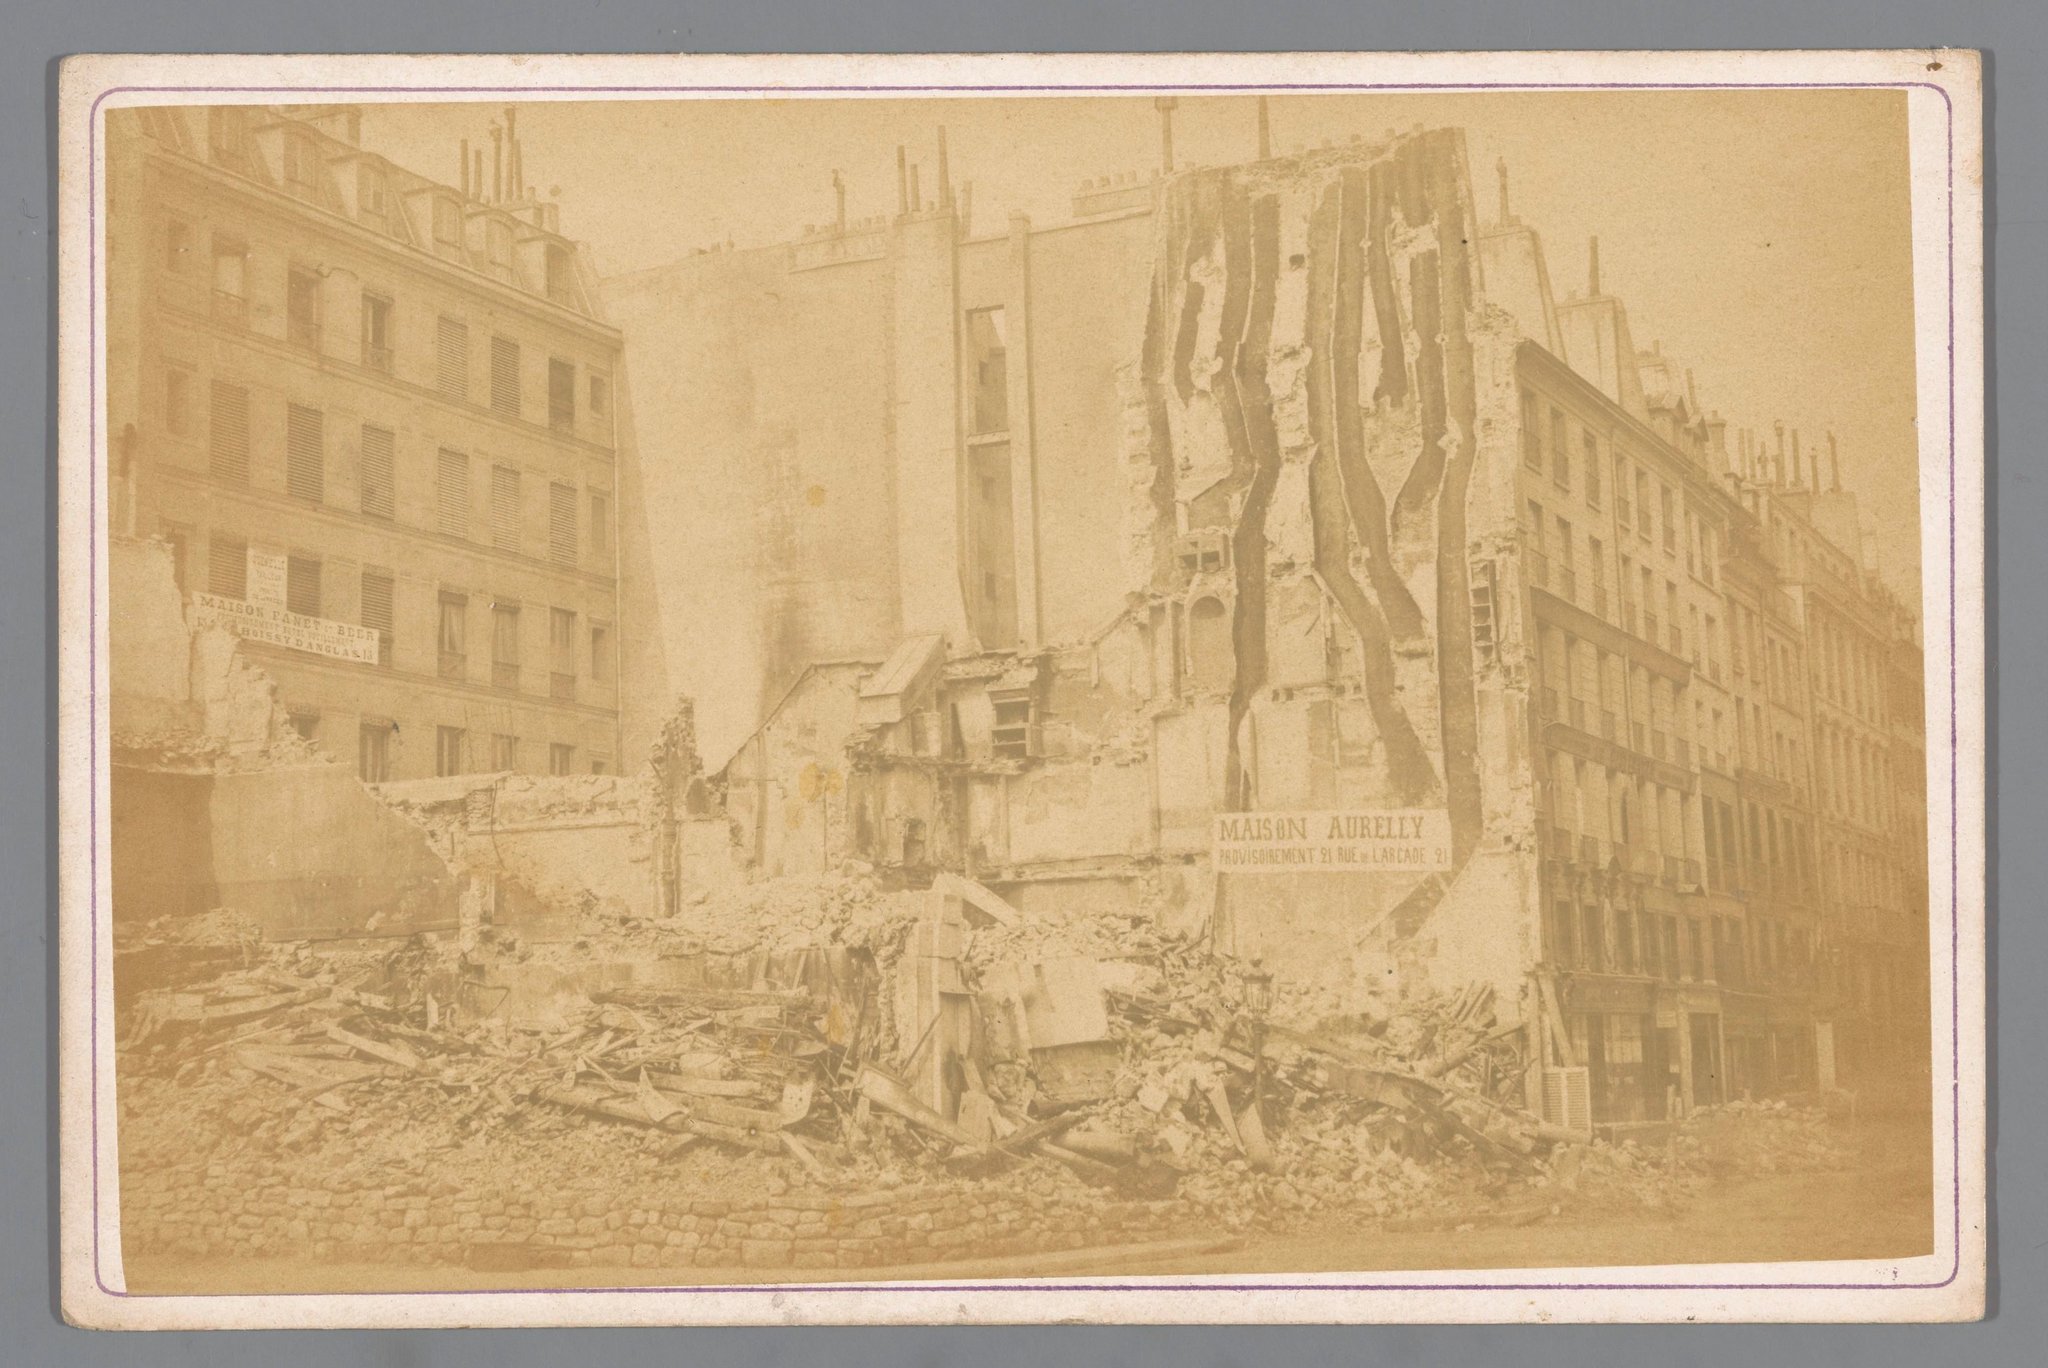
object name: cabinet photograph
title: Gezicht op de Rue Royale in Parijs na de brand door de Commune van Parijs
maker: Anonymous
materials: cardboard, photographic support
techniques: albumen print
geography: paris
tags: ruin of a building ~ architecture, street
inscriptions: annotation: ‘Rue Royale’